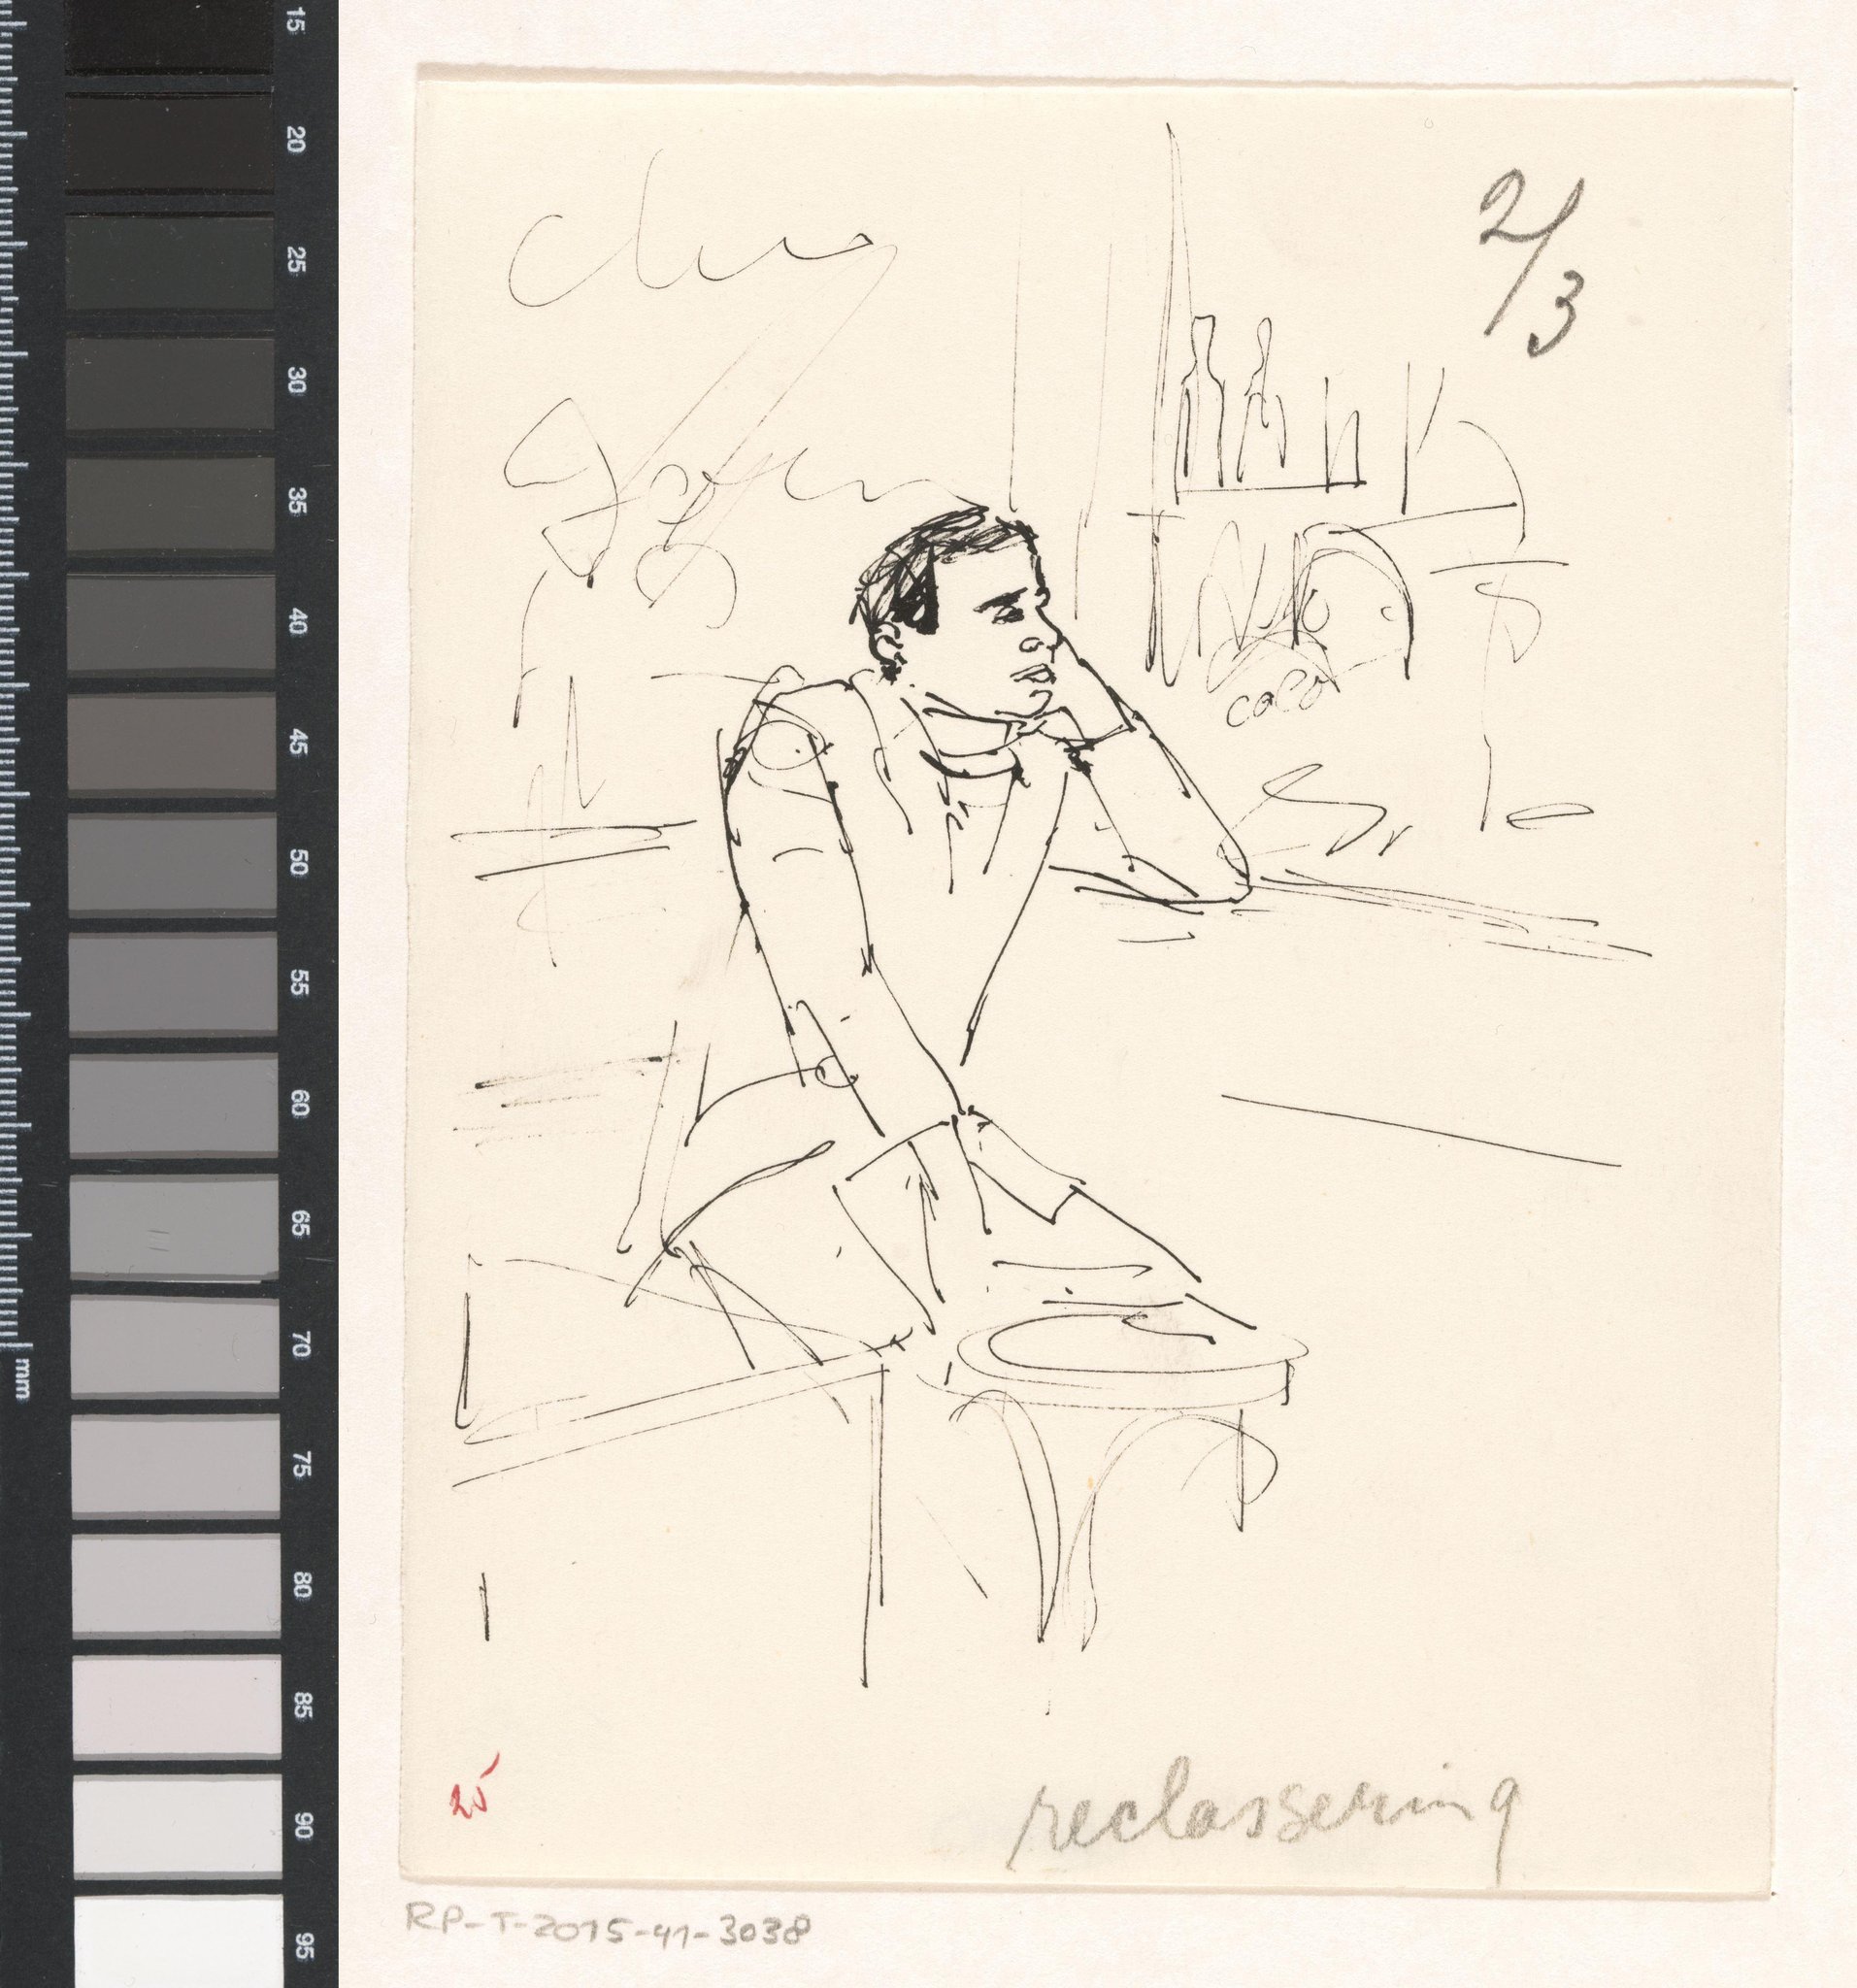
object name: boekillustratie ontwerp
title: Man in een bar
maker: Anonymous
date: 1930-1970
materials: ink, paper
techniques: pen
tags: sitting figure, inn, coffee-house, public house, etc.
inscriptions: number: ‘25’, collector's mark: Lugt 2228a, :, annotation: ‘reclassering’